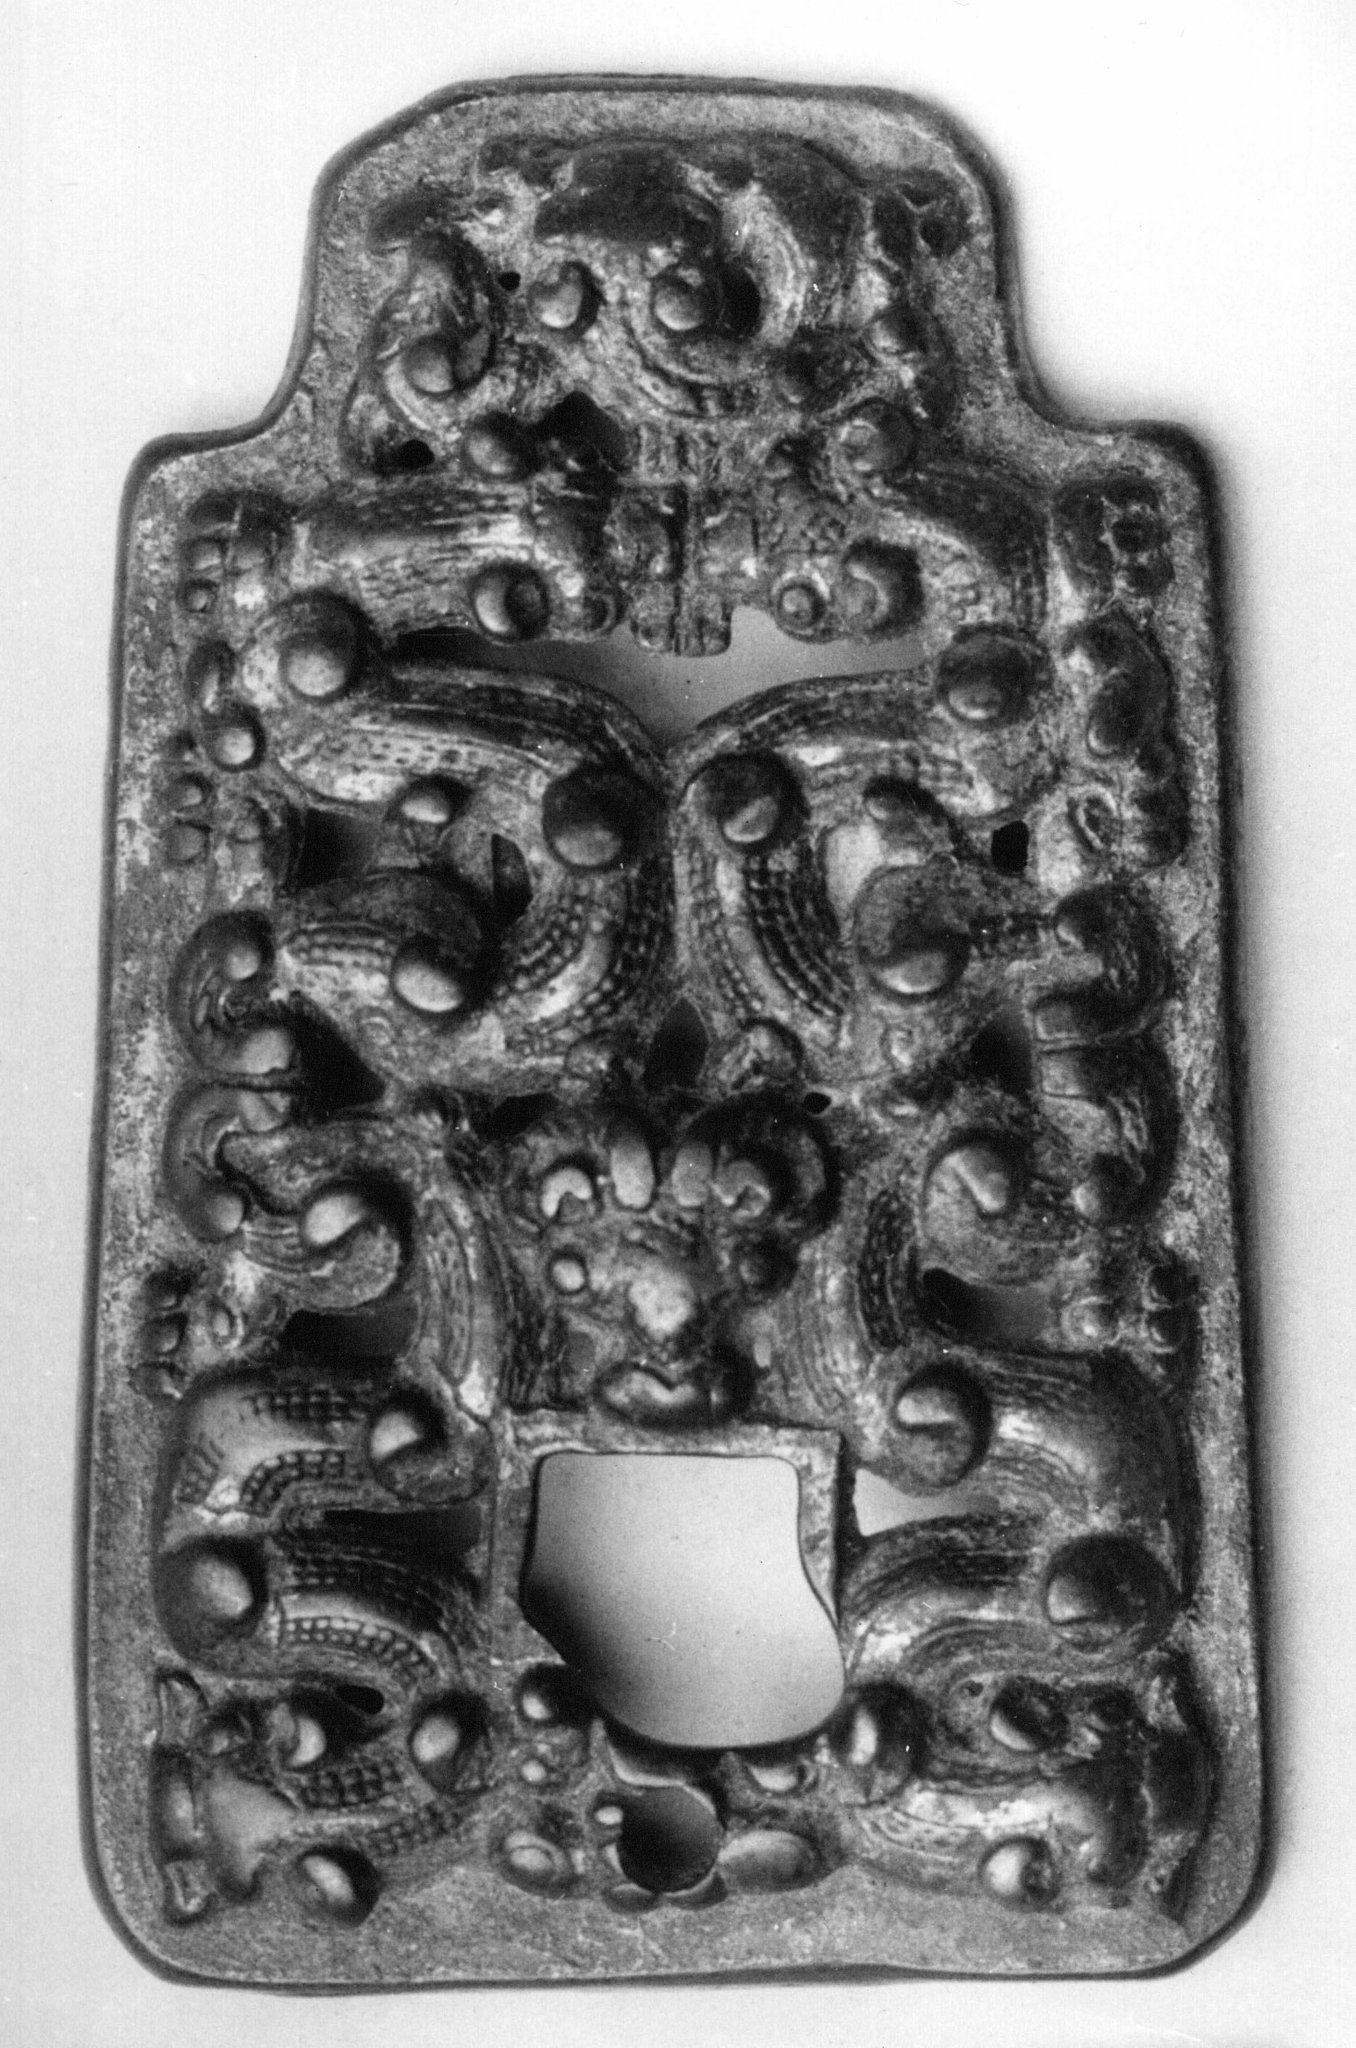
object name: fitting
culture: chinese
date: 221-206 BCE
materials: bronze